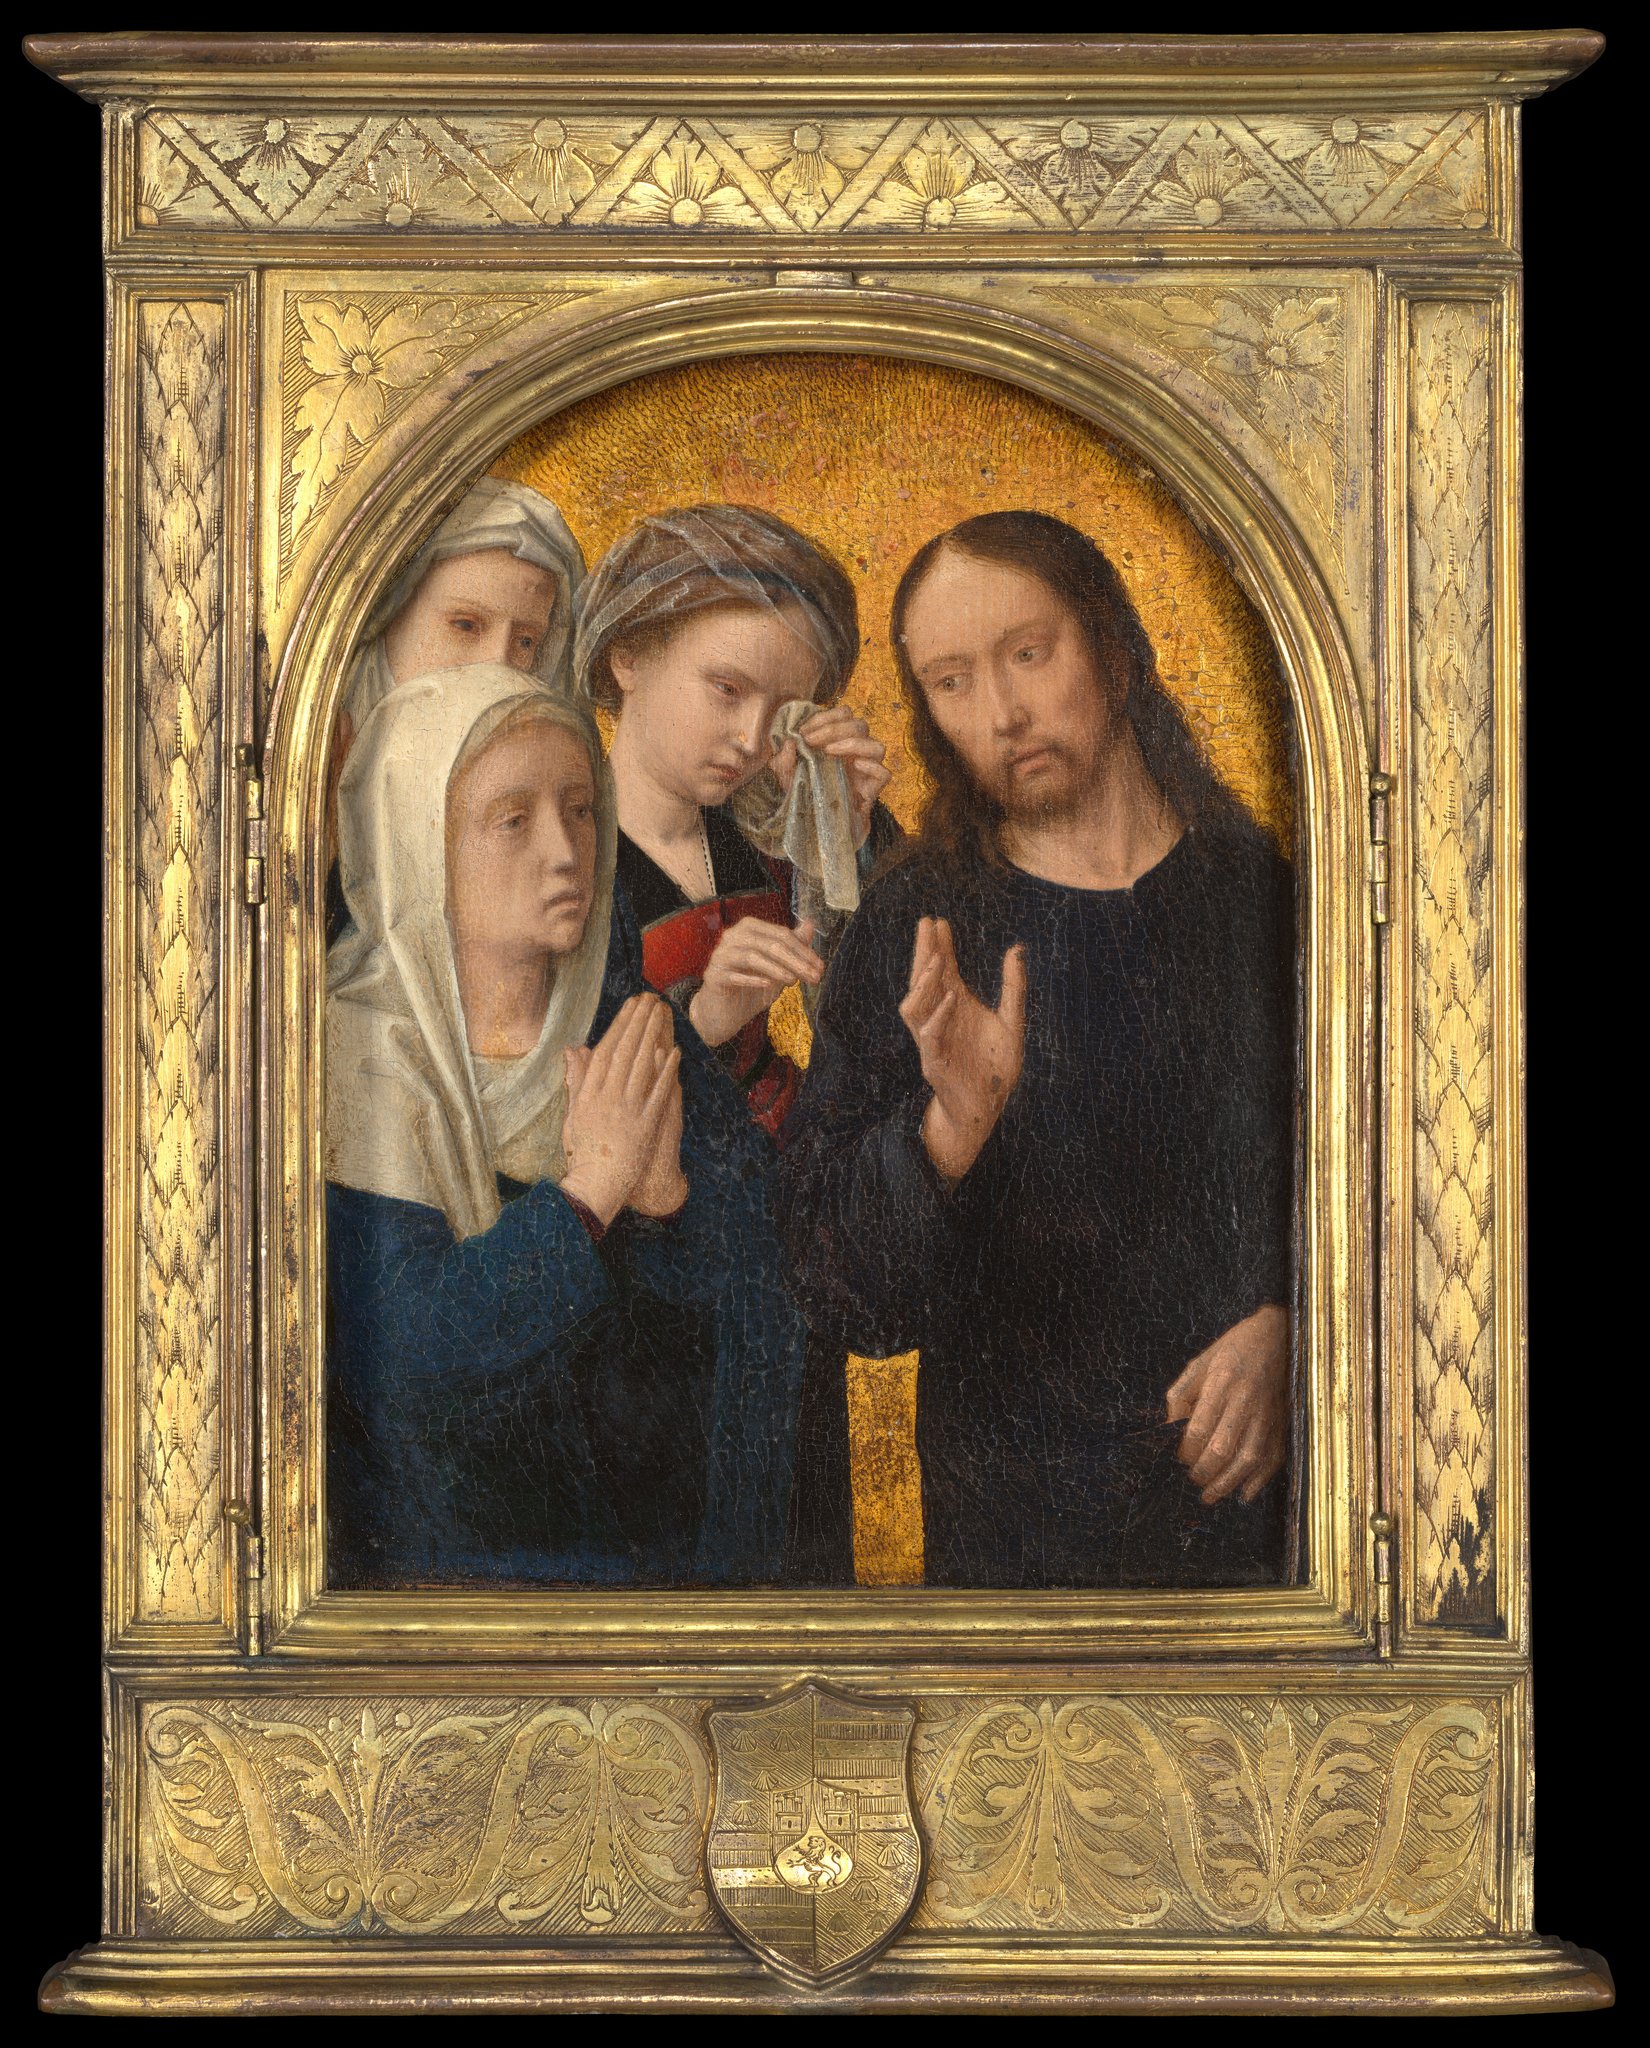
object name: painting, right wing of a diptych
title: Christ Taking Leave of His Mother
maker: gerard david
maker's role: artist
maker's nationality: netherlandish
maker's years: 1455-1523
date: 1500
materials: oil, wood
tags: sadness,women,christ,virgin mary